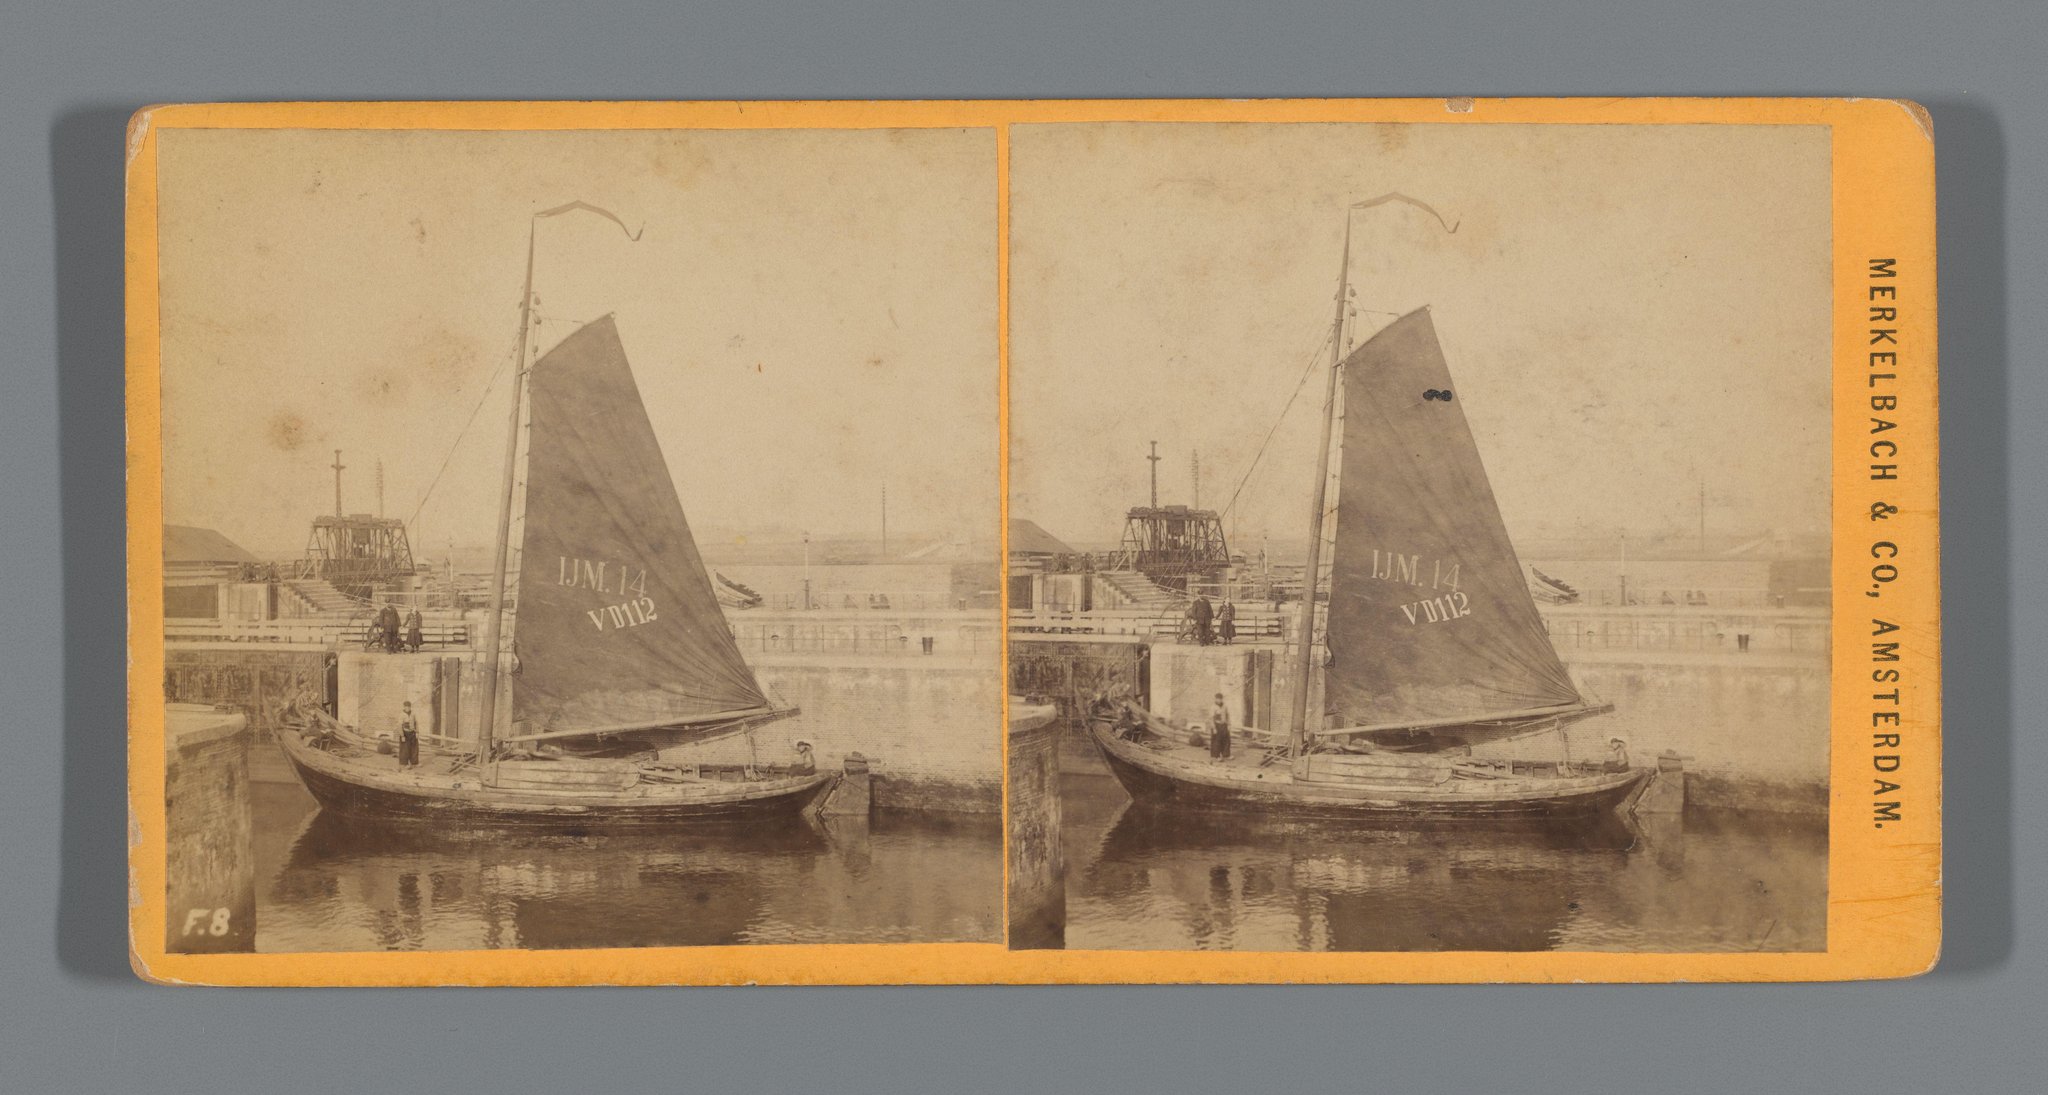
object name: stereograph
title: Aardrijkskundige Beeldengalerij, verzameld door M.J. Broekhuijsen, Hoofd eener school te Amsterdam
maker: martien johan broekhuijsen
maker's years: 1871-1956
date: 1905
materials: photographic support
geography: amsterdam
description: Onderdeel van een groep van 52 stereofoto's gebruikt in het lager onderwijs als aanvulling op schoolplaten. De gehele reeks bestond uit 274 nummers in 10 categorieën (A t/m K).